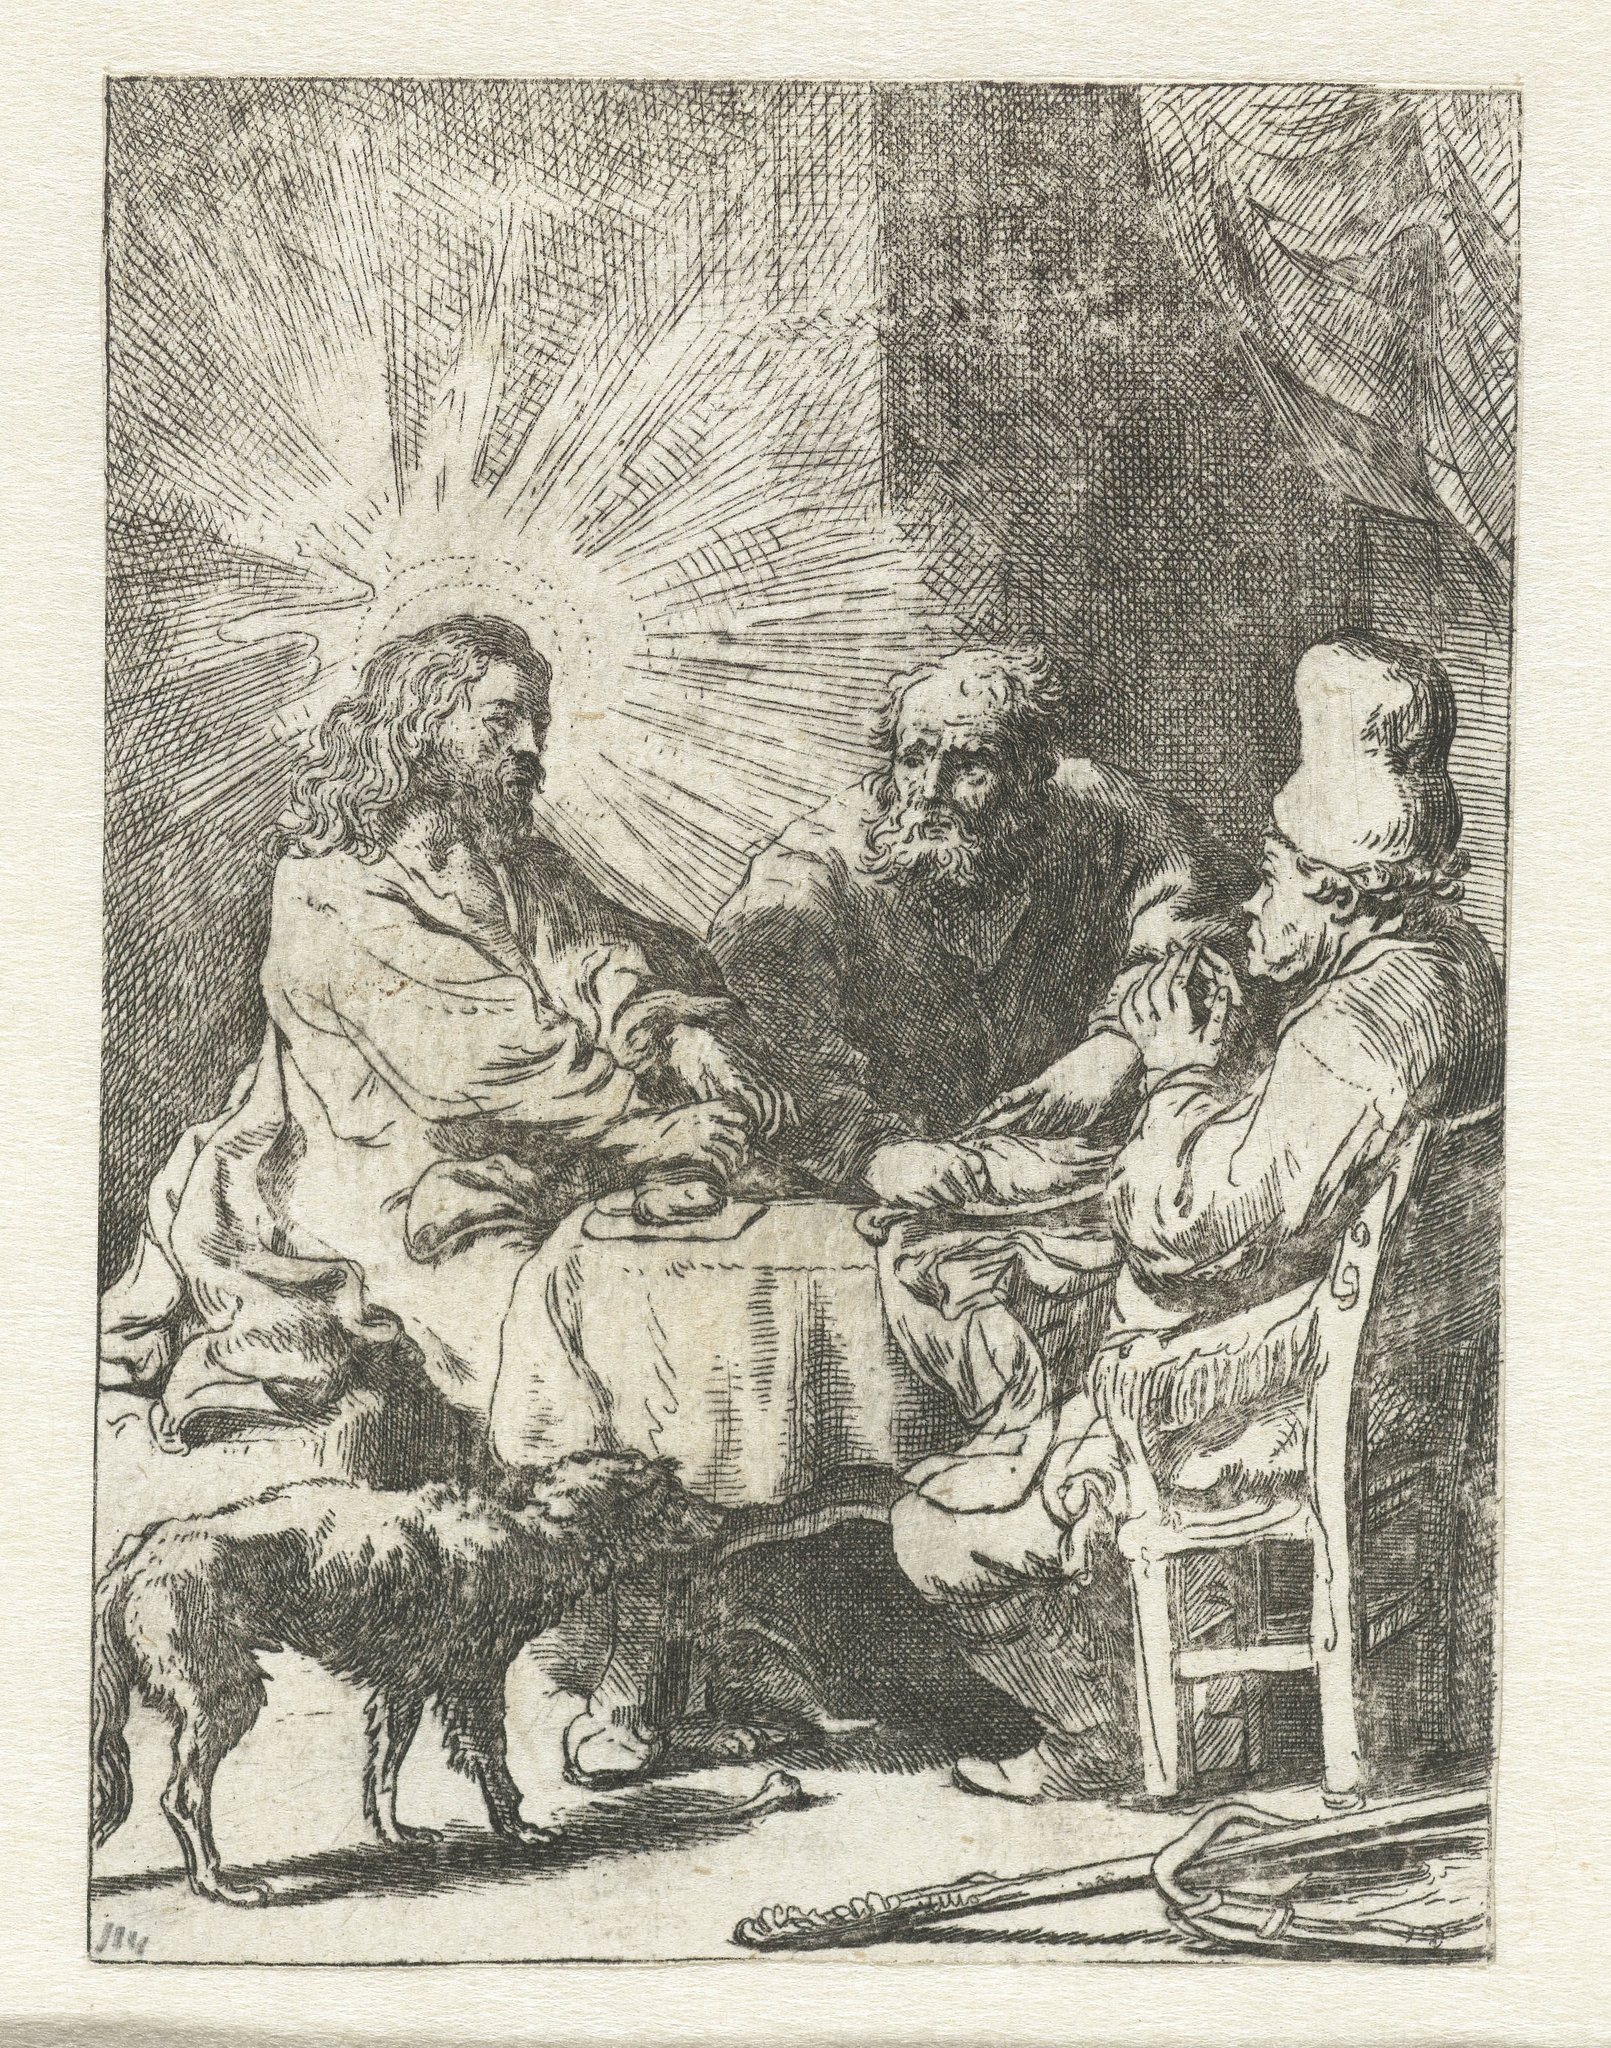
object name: print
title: Christus at Emmaus: the smaller plate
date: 1711-1800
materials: paper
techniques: etching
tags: the supper at emmaus: christ is recognized while blessing or breaking the bread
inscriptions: number, collector's mark: Lugt 2760, collector's mark: Lugt 2228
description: Spiegelbeeldige kopie naar de gelijknamige prent van Rembrandt.